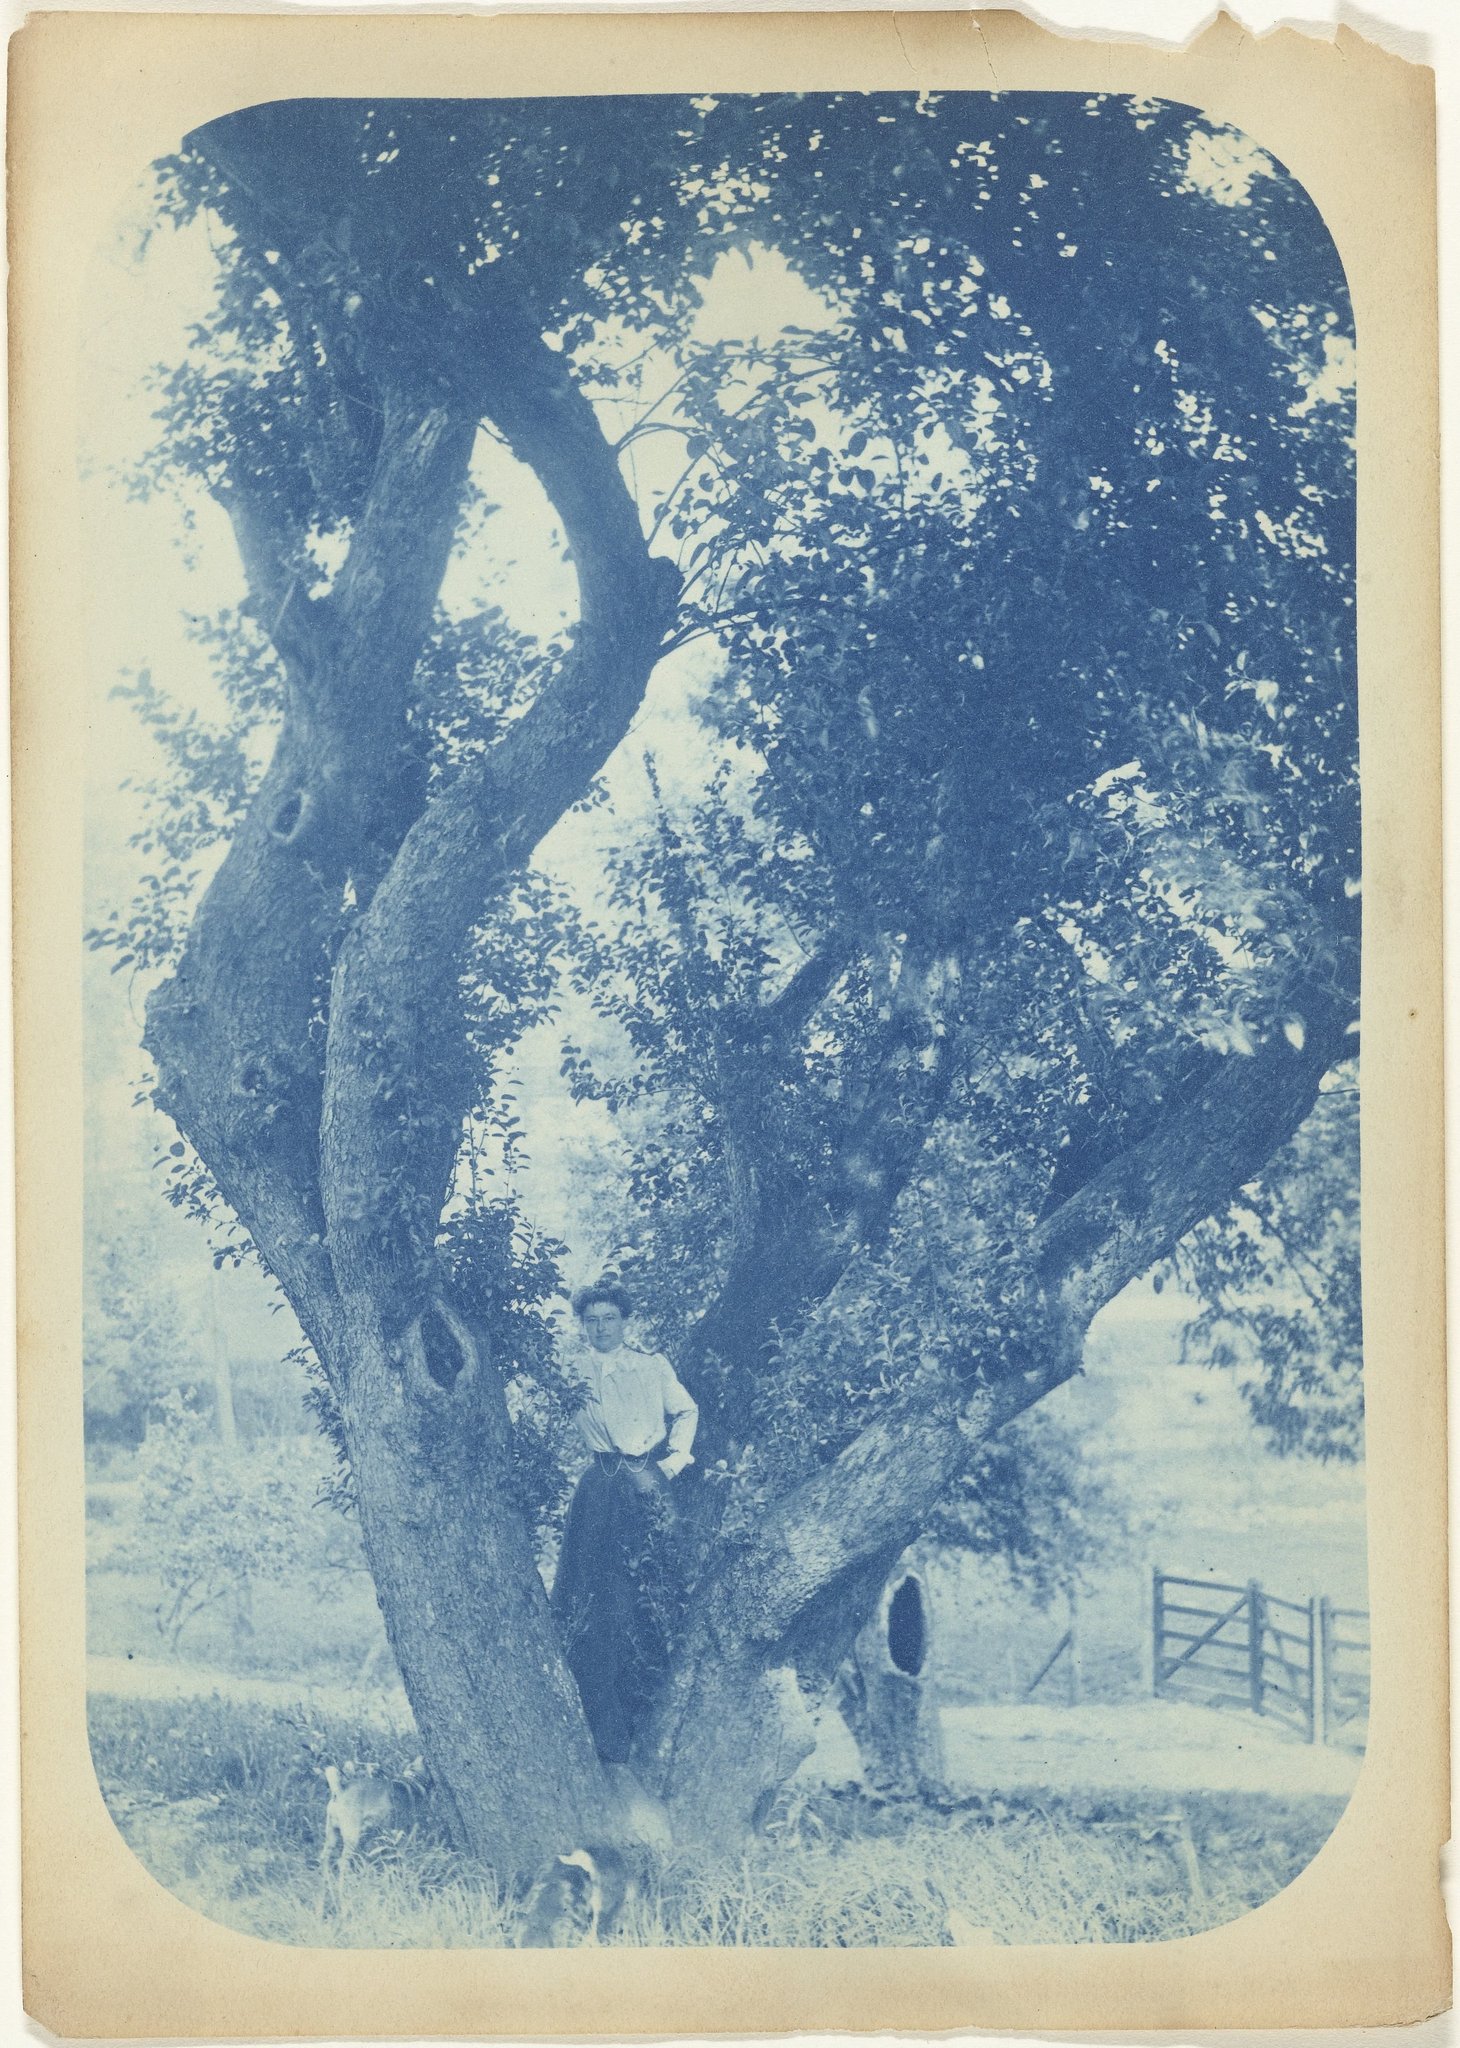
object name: photograph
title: Vrouw staand in een knotwilg, twee honden naast de boomstam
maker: Anonymous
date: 1890-1920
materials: paper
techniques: cyanotype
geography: united states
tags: adult woman, trees: willow, dog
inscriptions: inscription: ‘0363’